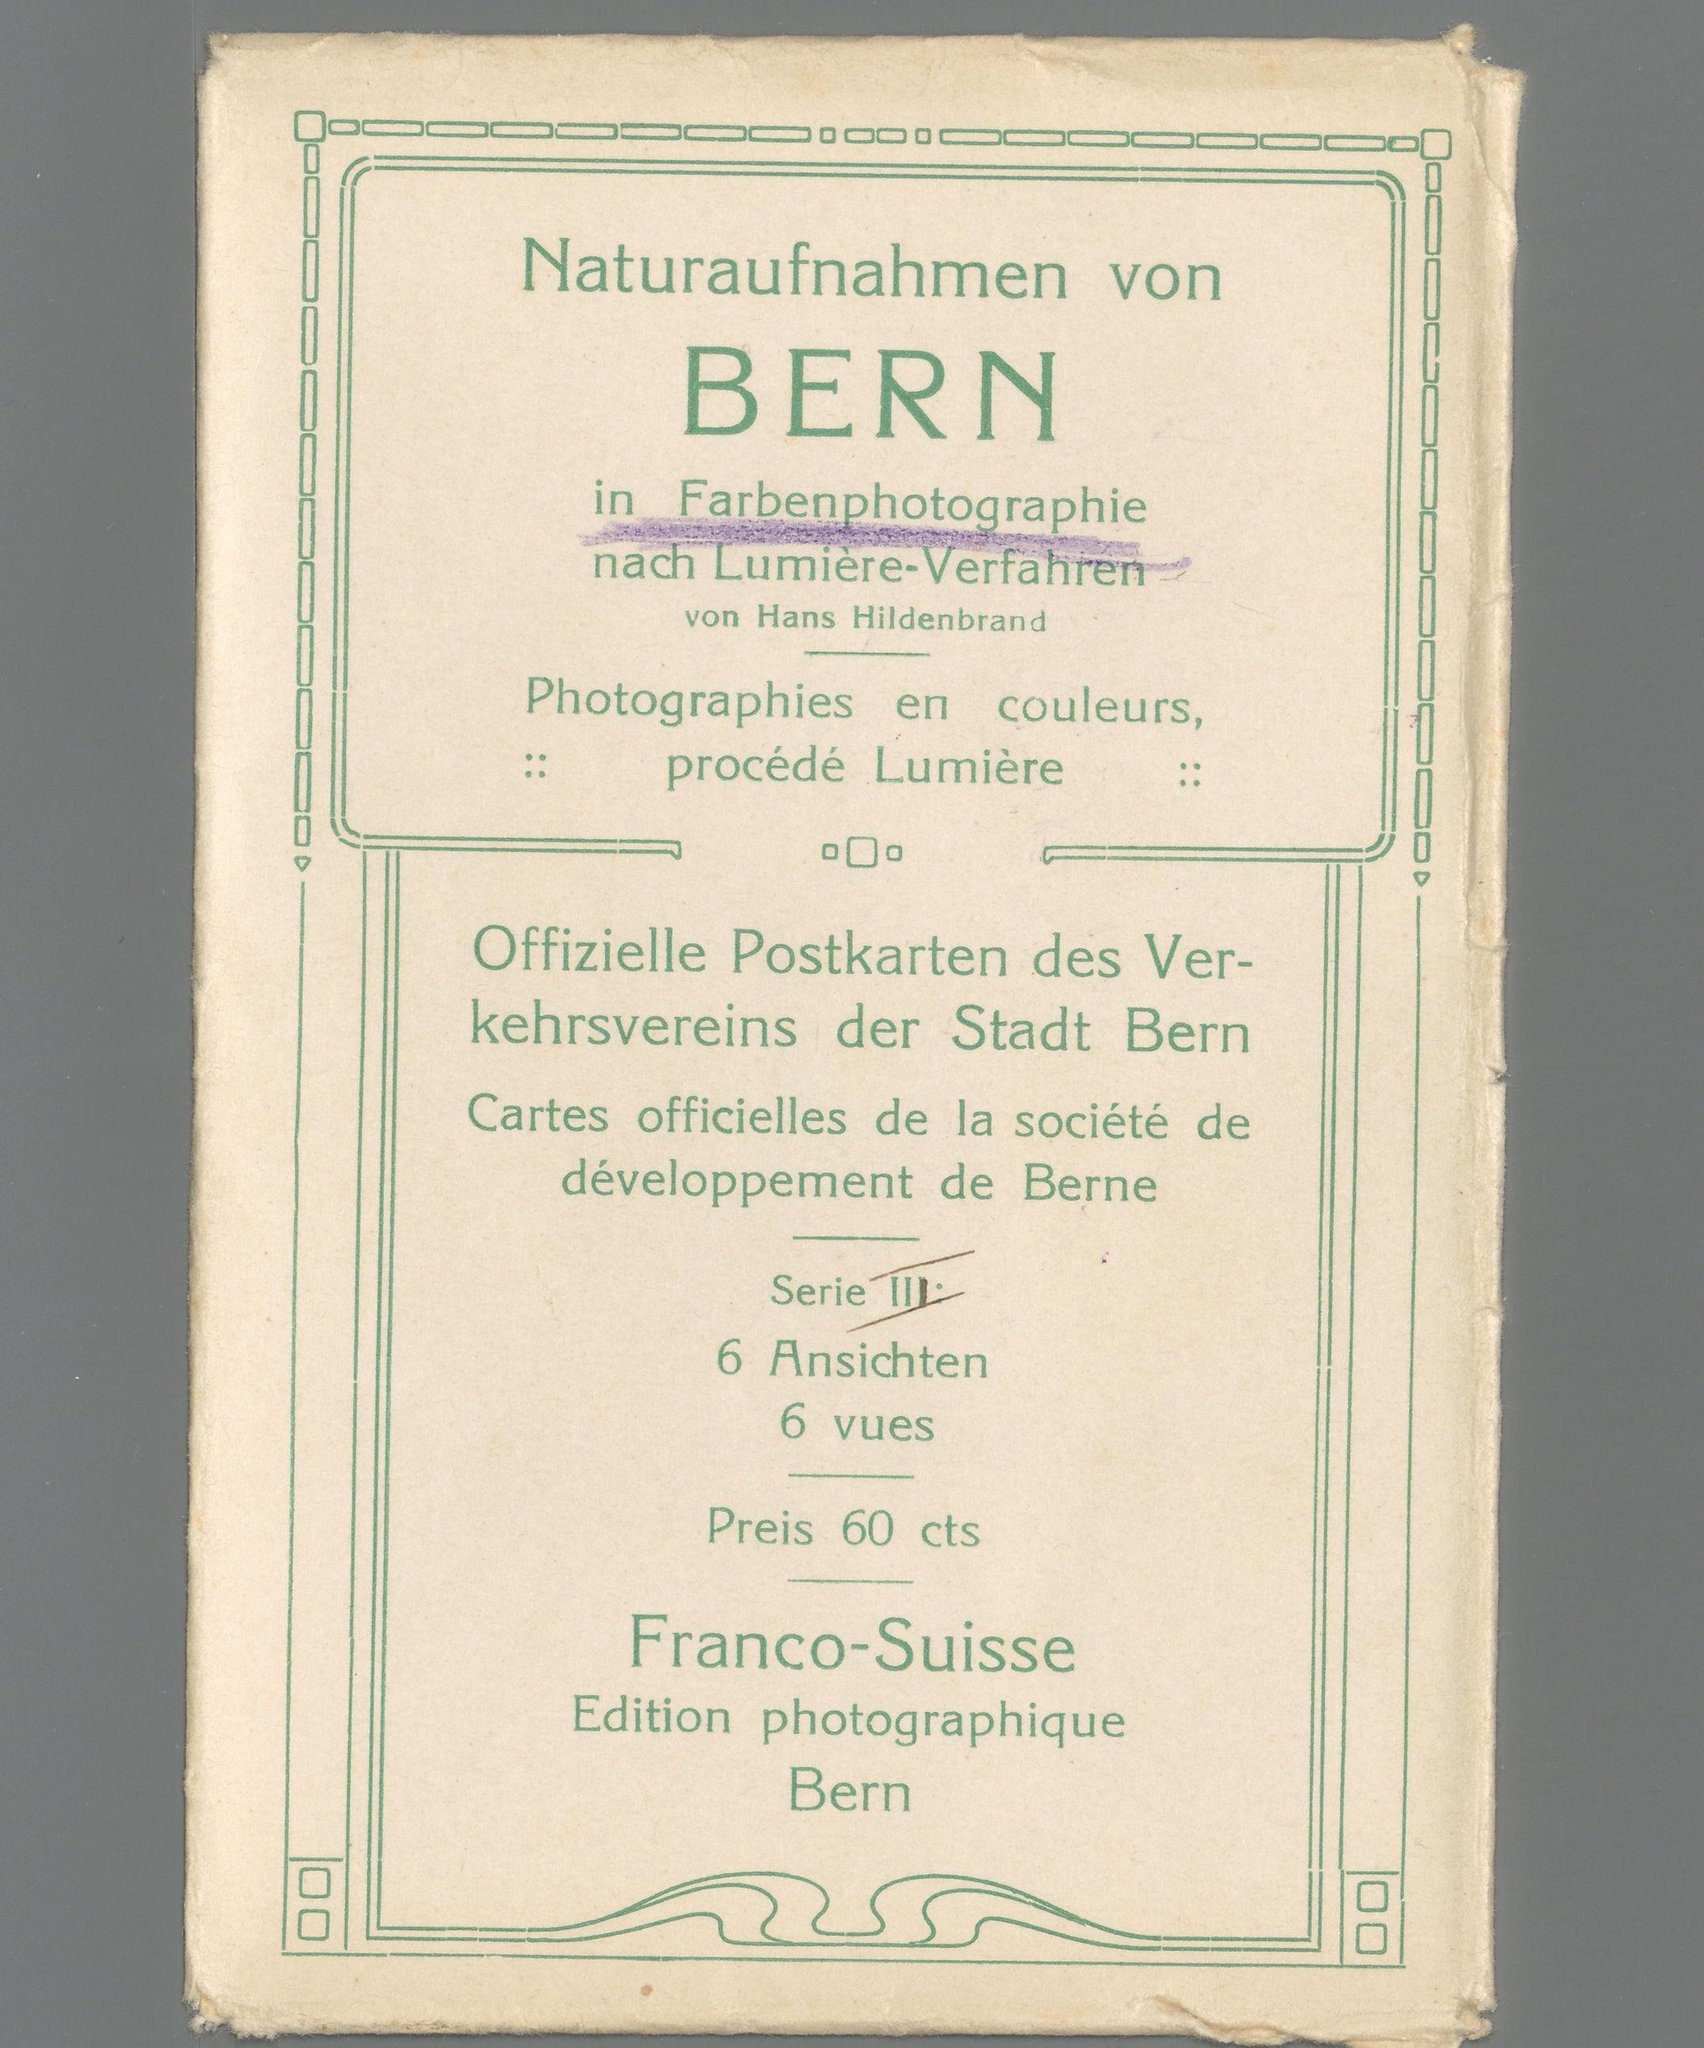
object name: wrapper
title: Omslag voor vier prentbriefkaarten van Bern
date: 1909-1930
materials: paper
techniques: letterpress printing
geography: bern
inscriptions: stamp: ‘Carl Marz, Bern. Marktgasse 50. Buch- und Kunsthandlung. Antiquariat. Kunstsalon. Telephon 3786’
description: Het omslag is bedoeld voor zes prentbriefkaarten. In dit exemplaar zijn vier prentbriefkaarten aangetroffen.